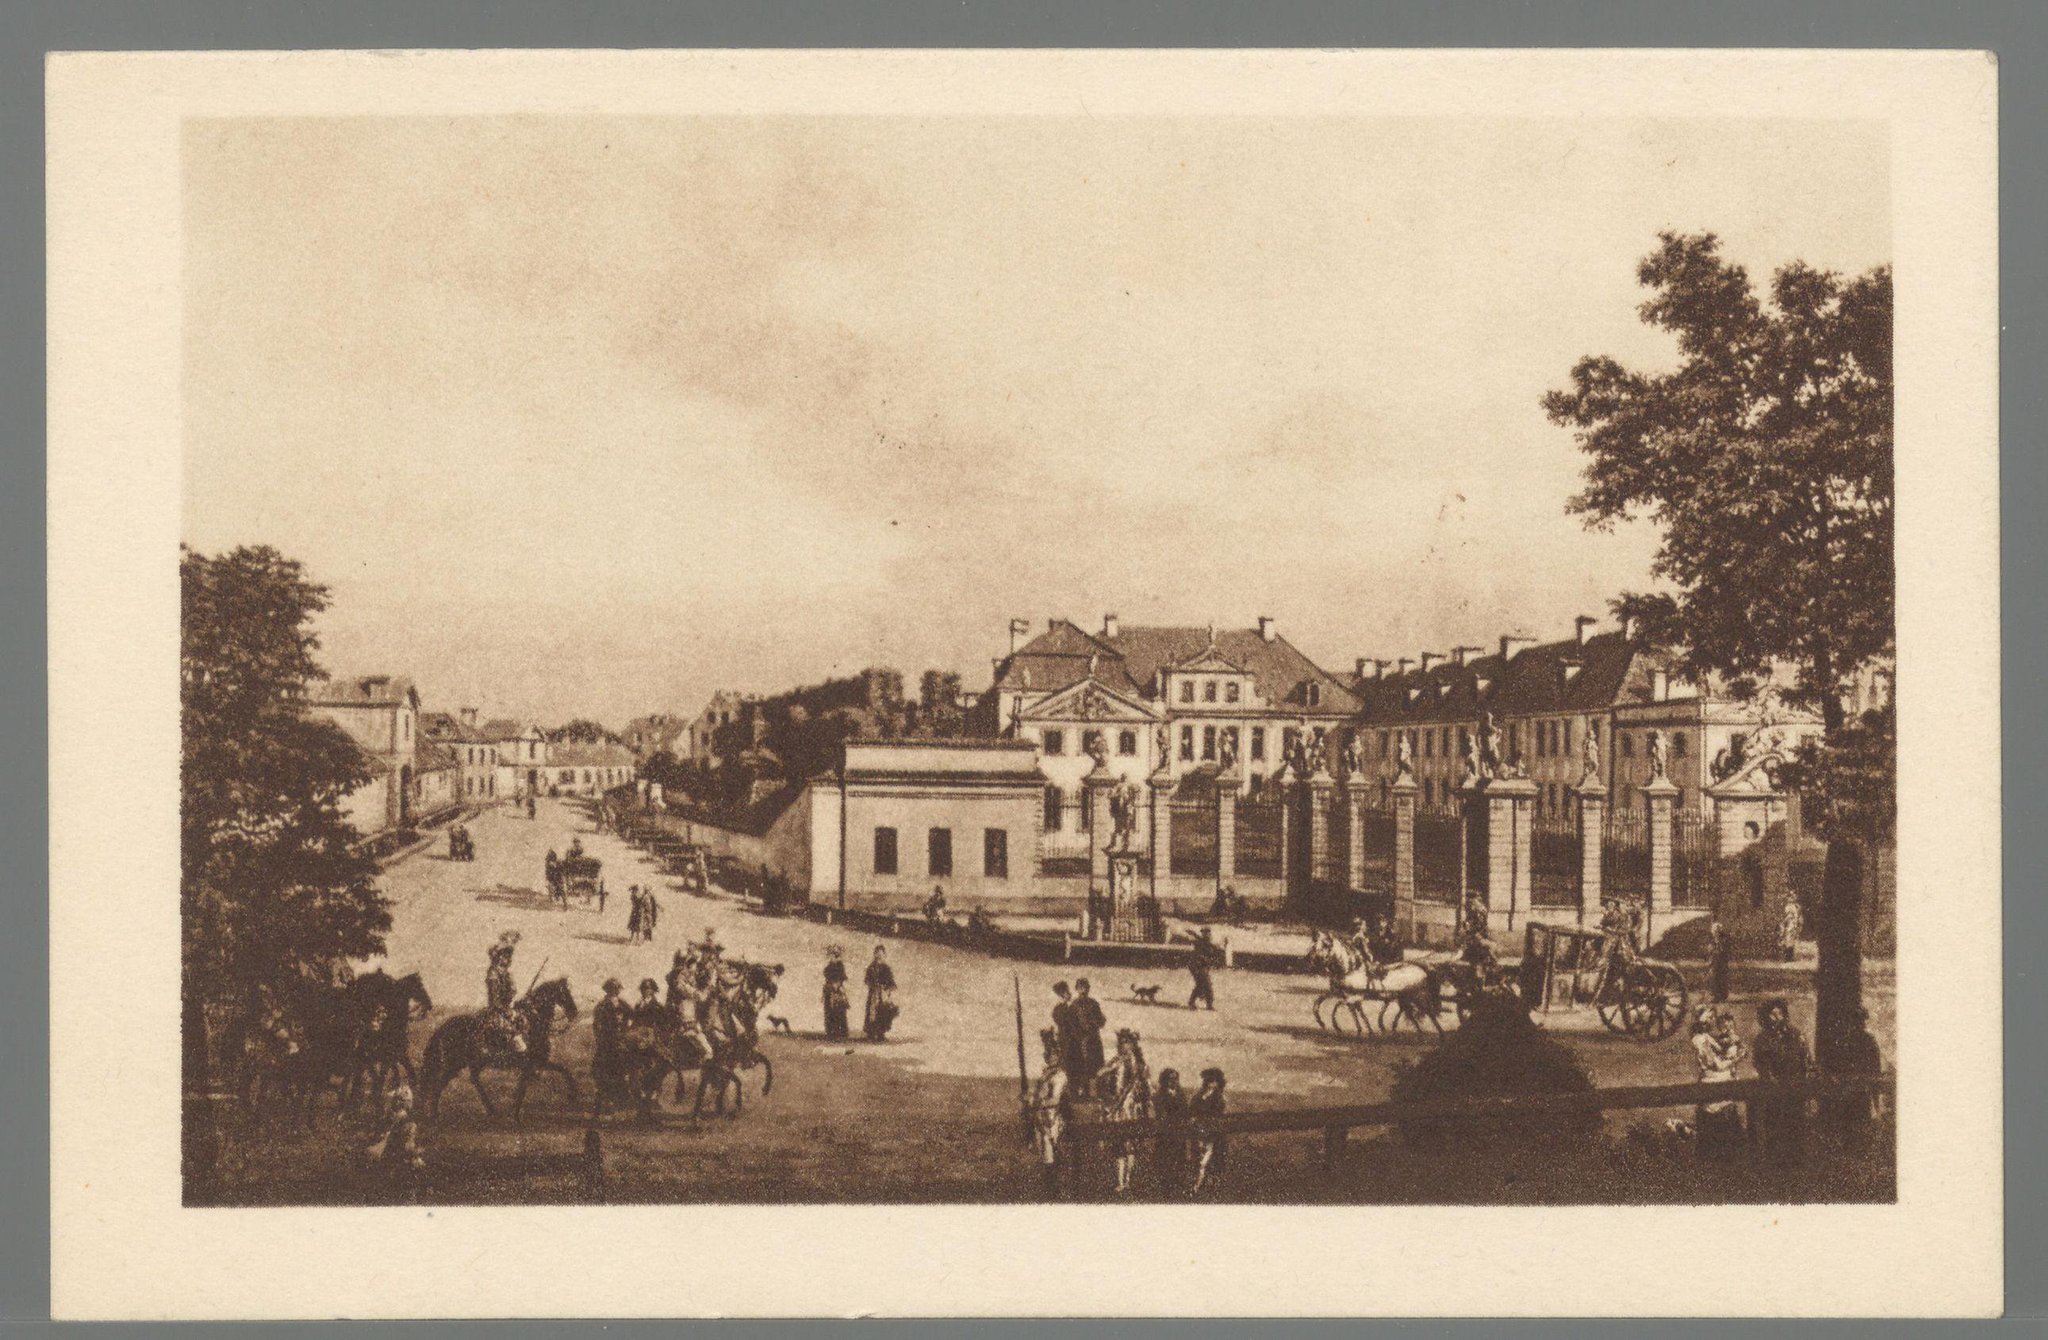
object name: ansichtkaart, prentbriefkaart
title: Zicht op het Blauwe Paleis in Warschau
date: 1920-1960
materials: cardboard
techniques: rotogravure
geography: warsaw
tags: palace, city-view, and landscape with man-made constructions (+ city(-scape) with figures, staffage)